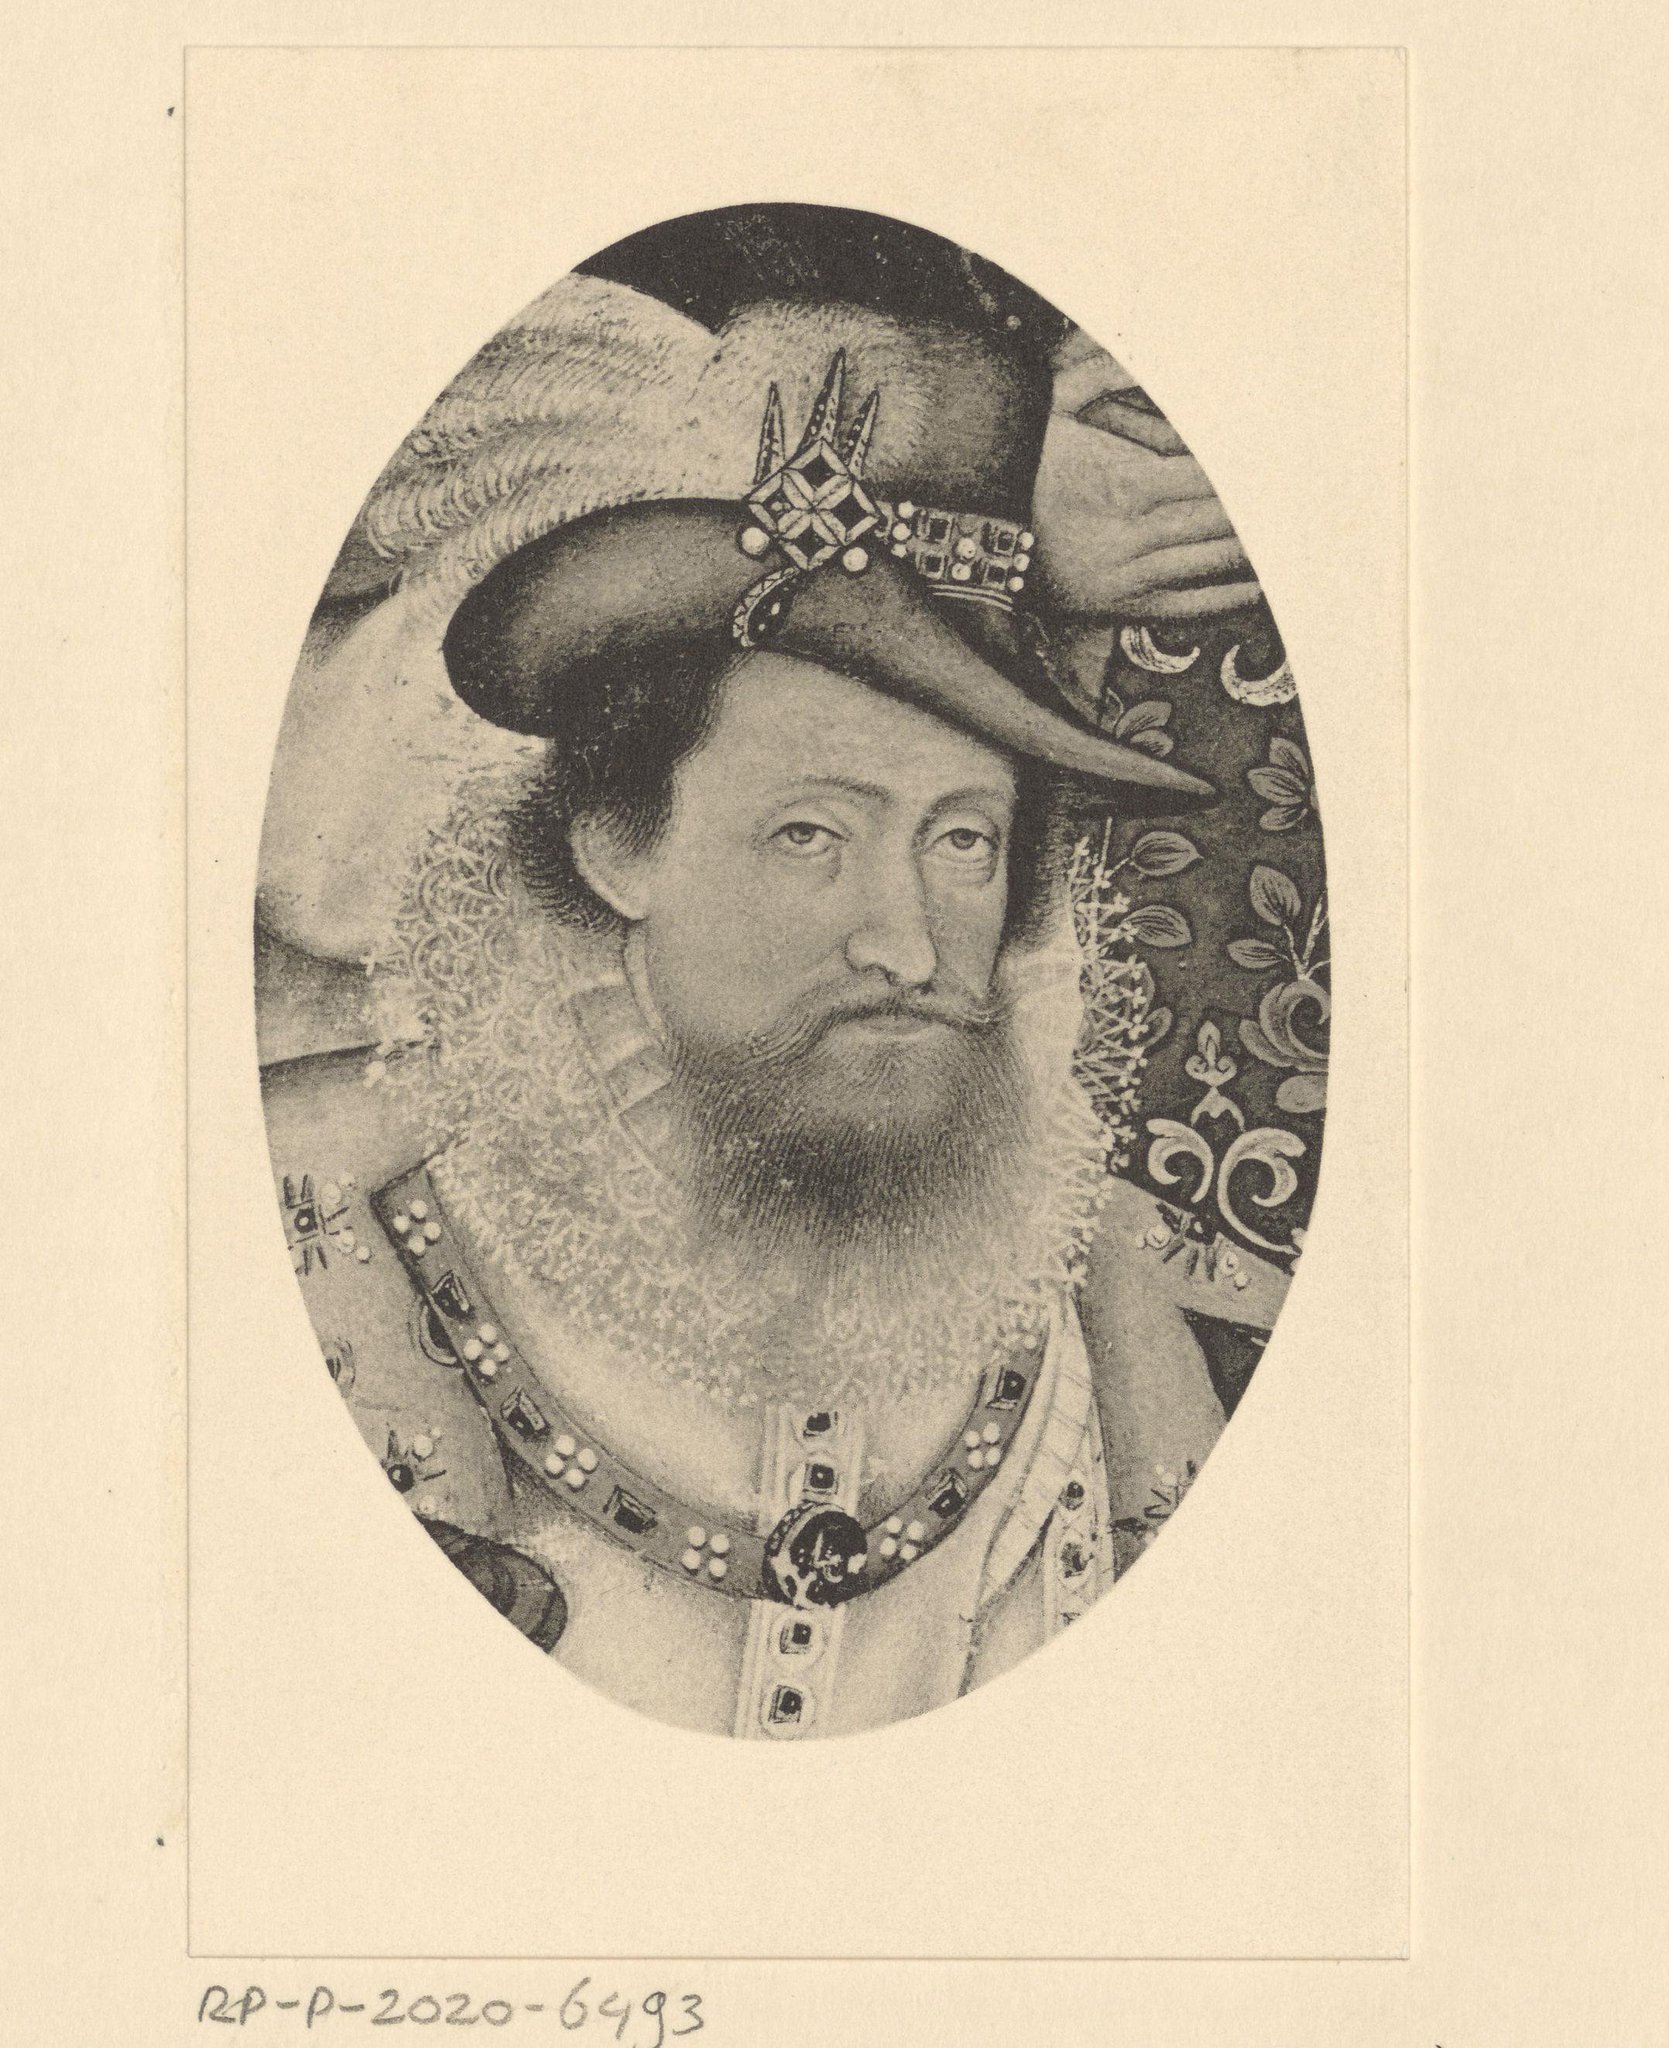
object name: reproduction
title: The English King James I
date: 1905-1940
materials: cardboard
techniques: photograph, letterpress printing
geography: meriden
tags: jacobus i (koning van engeland), historical persons, king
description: Het portret van Jacobus I op deze prentbriefkaart is een detail van de miniatuurschildering 'Jahangir verkiest een Sufi Shaikh boven koningen' uit het St Petersburg Album in de collectie van de National Museum of Asian Art (Freer Gallery of Art en de Arthur M. Sackler Gallery) in Washington.